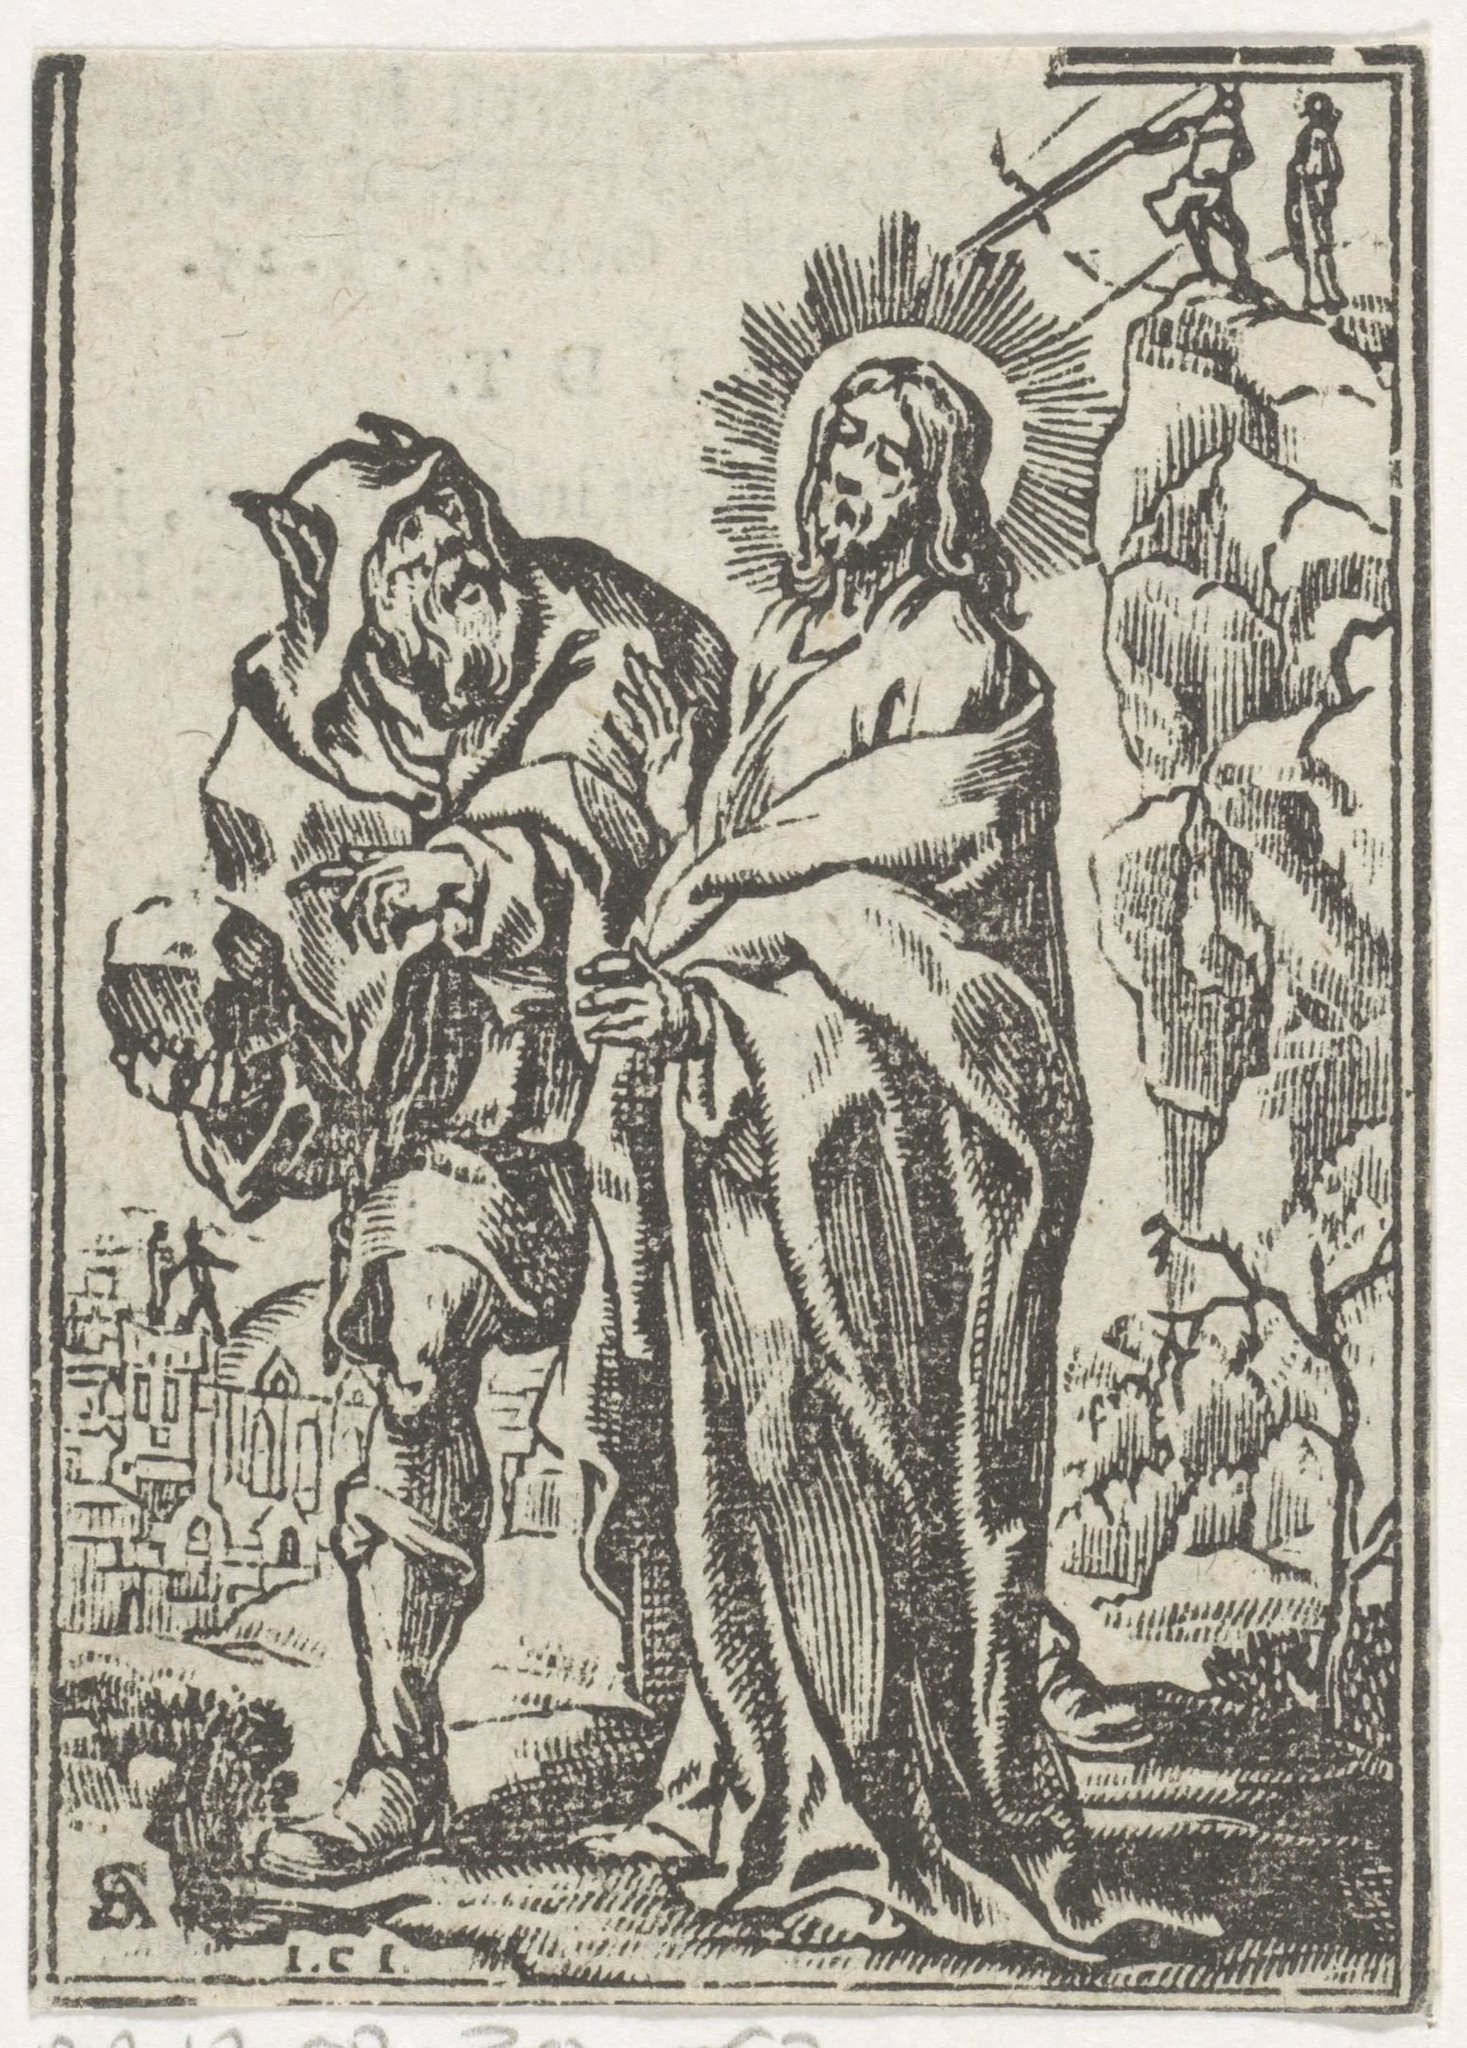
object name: print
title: Verzoeking van Christus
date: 1649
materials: paper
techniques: letterpress printing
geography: antwerp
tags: 'command these stones to become loaves of bread' ~ temptation of christ in the wilderness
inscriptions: collector's mark: Lugt 2228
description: De duivel in de gedaante van een oude man in monnikspij biedt Christus een steen aan en vraagt hem die in een brood te veranderen.